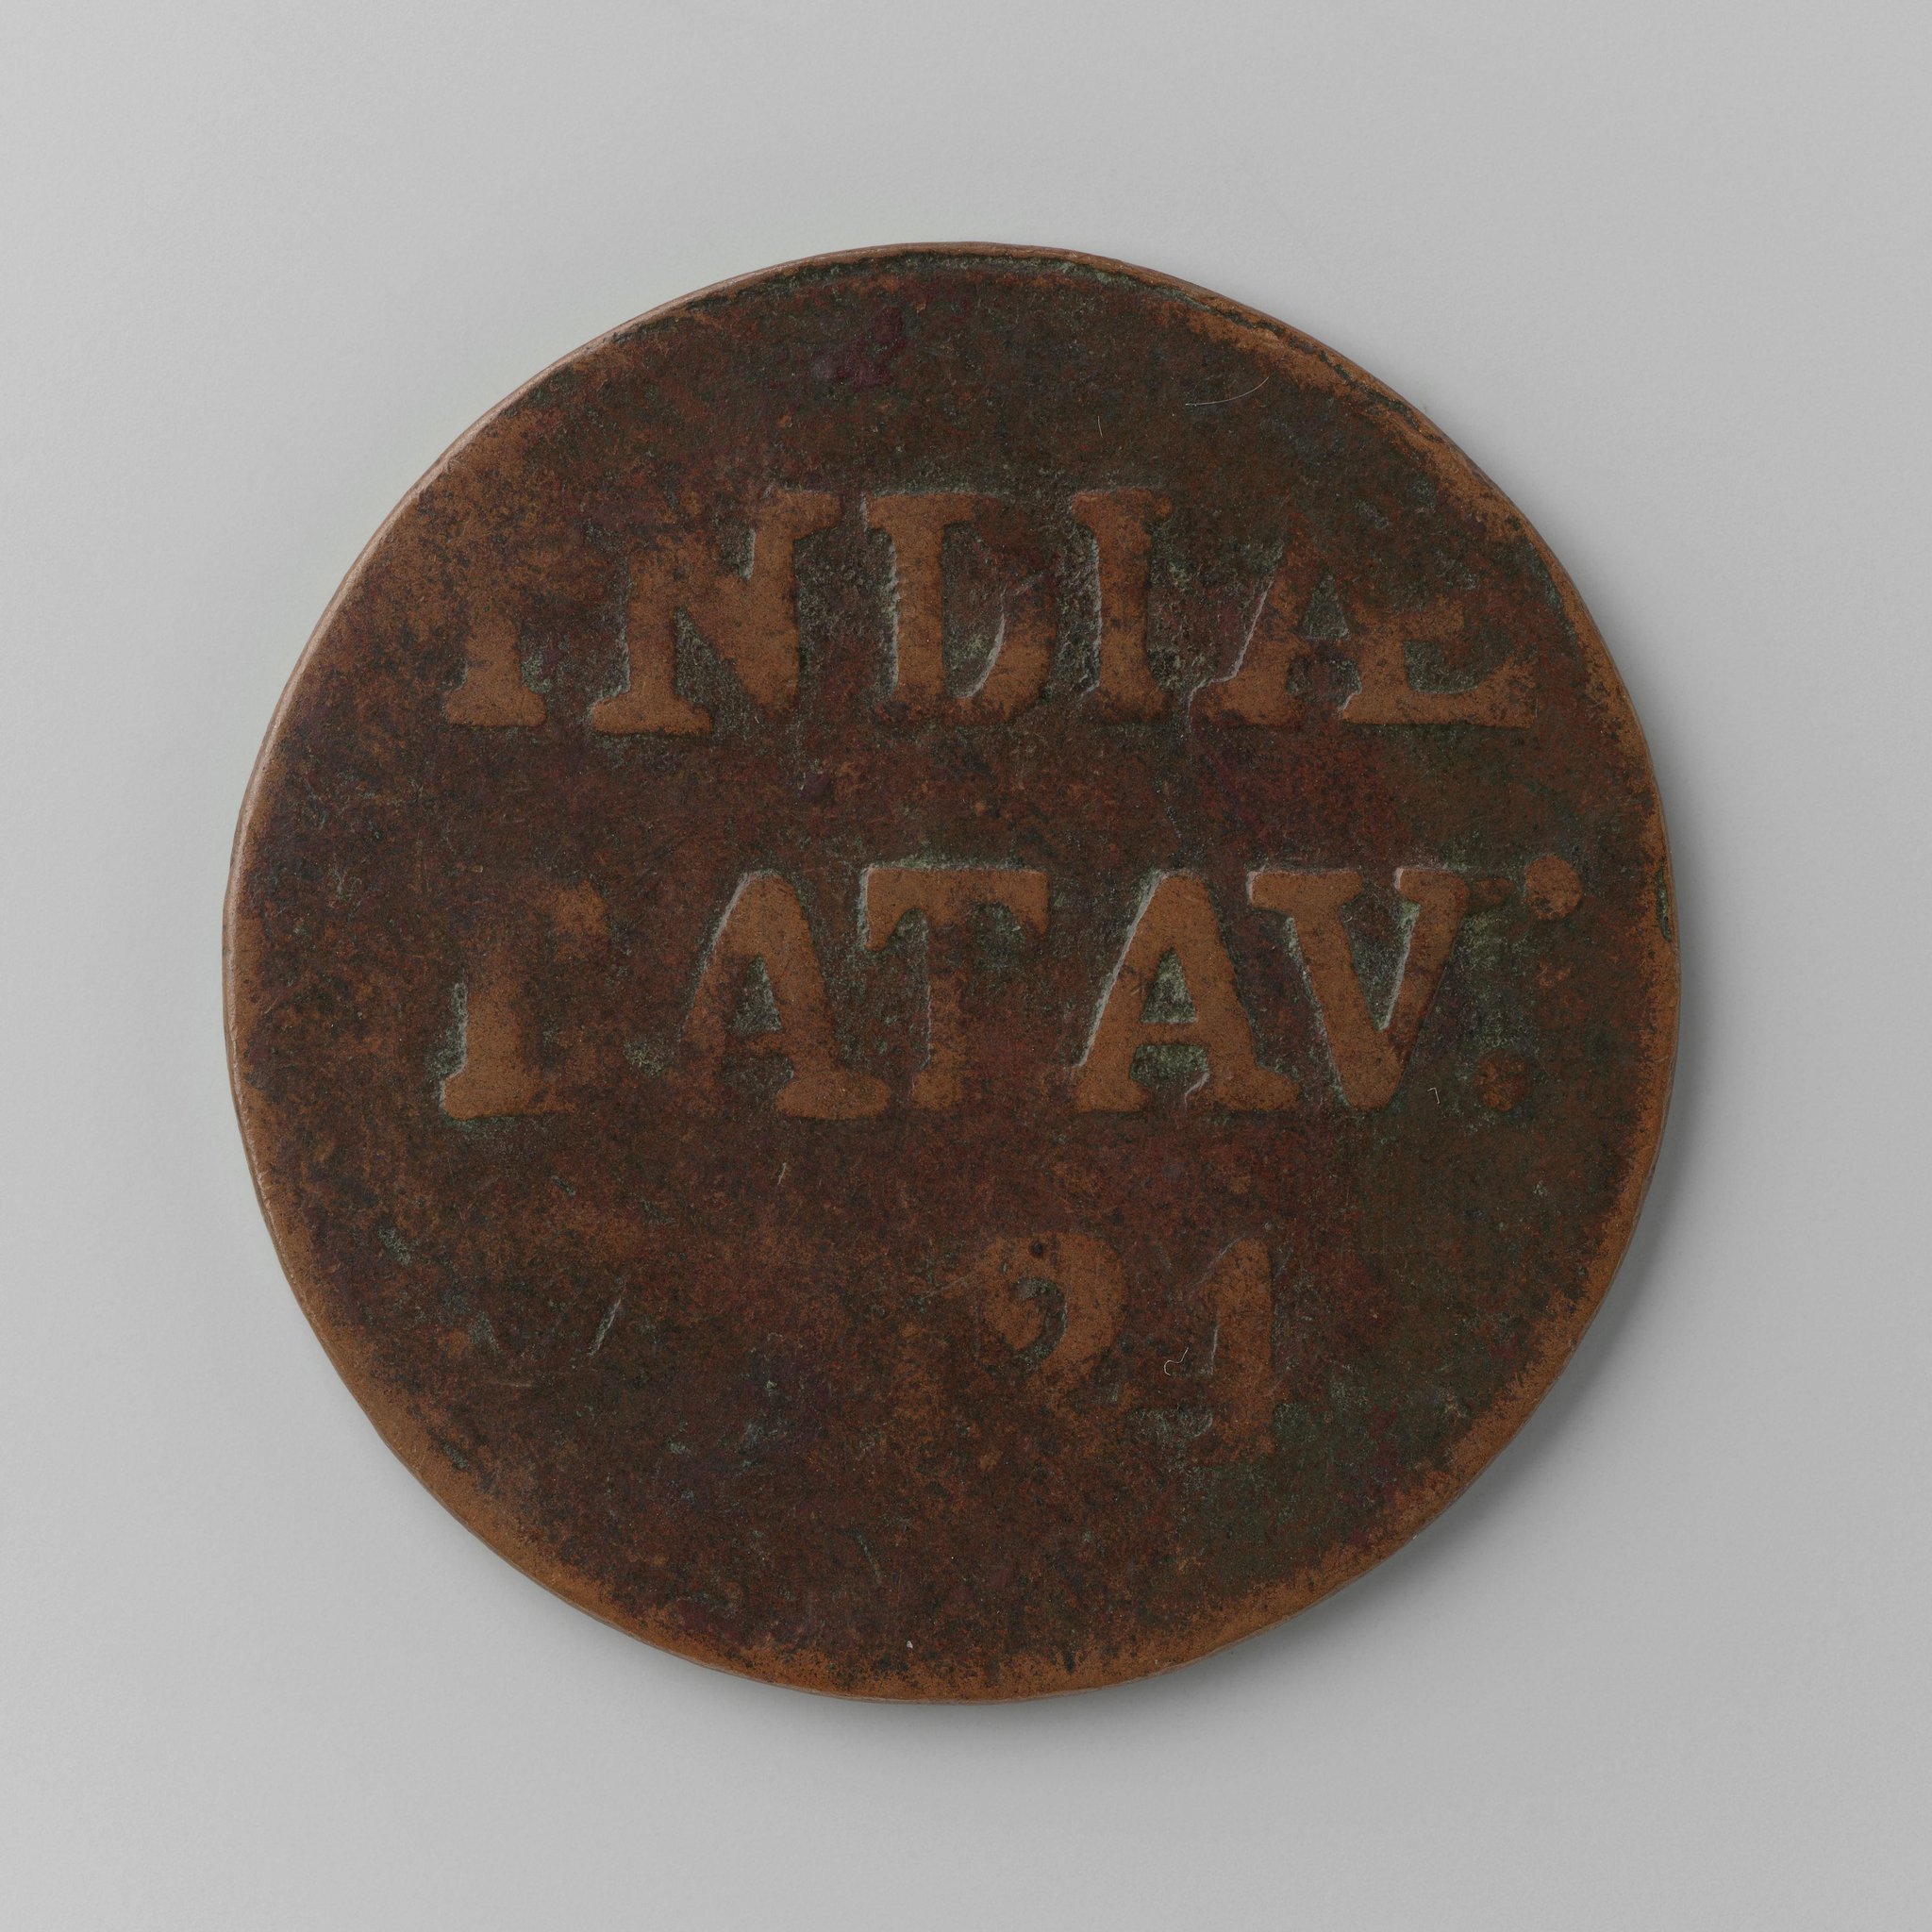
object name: coin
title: ½ stuiver van Nederlands Indië, 1824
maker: william i of the netherlands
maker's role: koning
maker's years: 1772-1843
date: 1824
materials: copper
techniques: striking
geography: surabaya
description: Koperen munt. Voorzijde: tussen waarde-aanduiding ½ St. gekroond generaliteitswapenschild. Keerzijde: tweeregelig opschrift, waarboven muntteken en waaronder jaartal. Gladde rand.